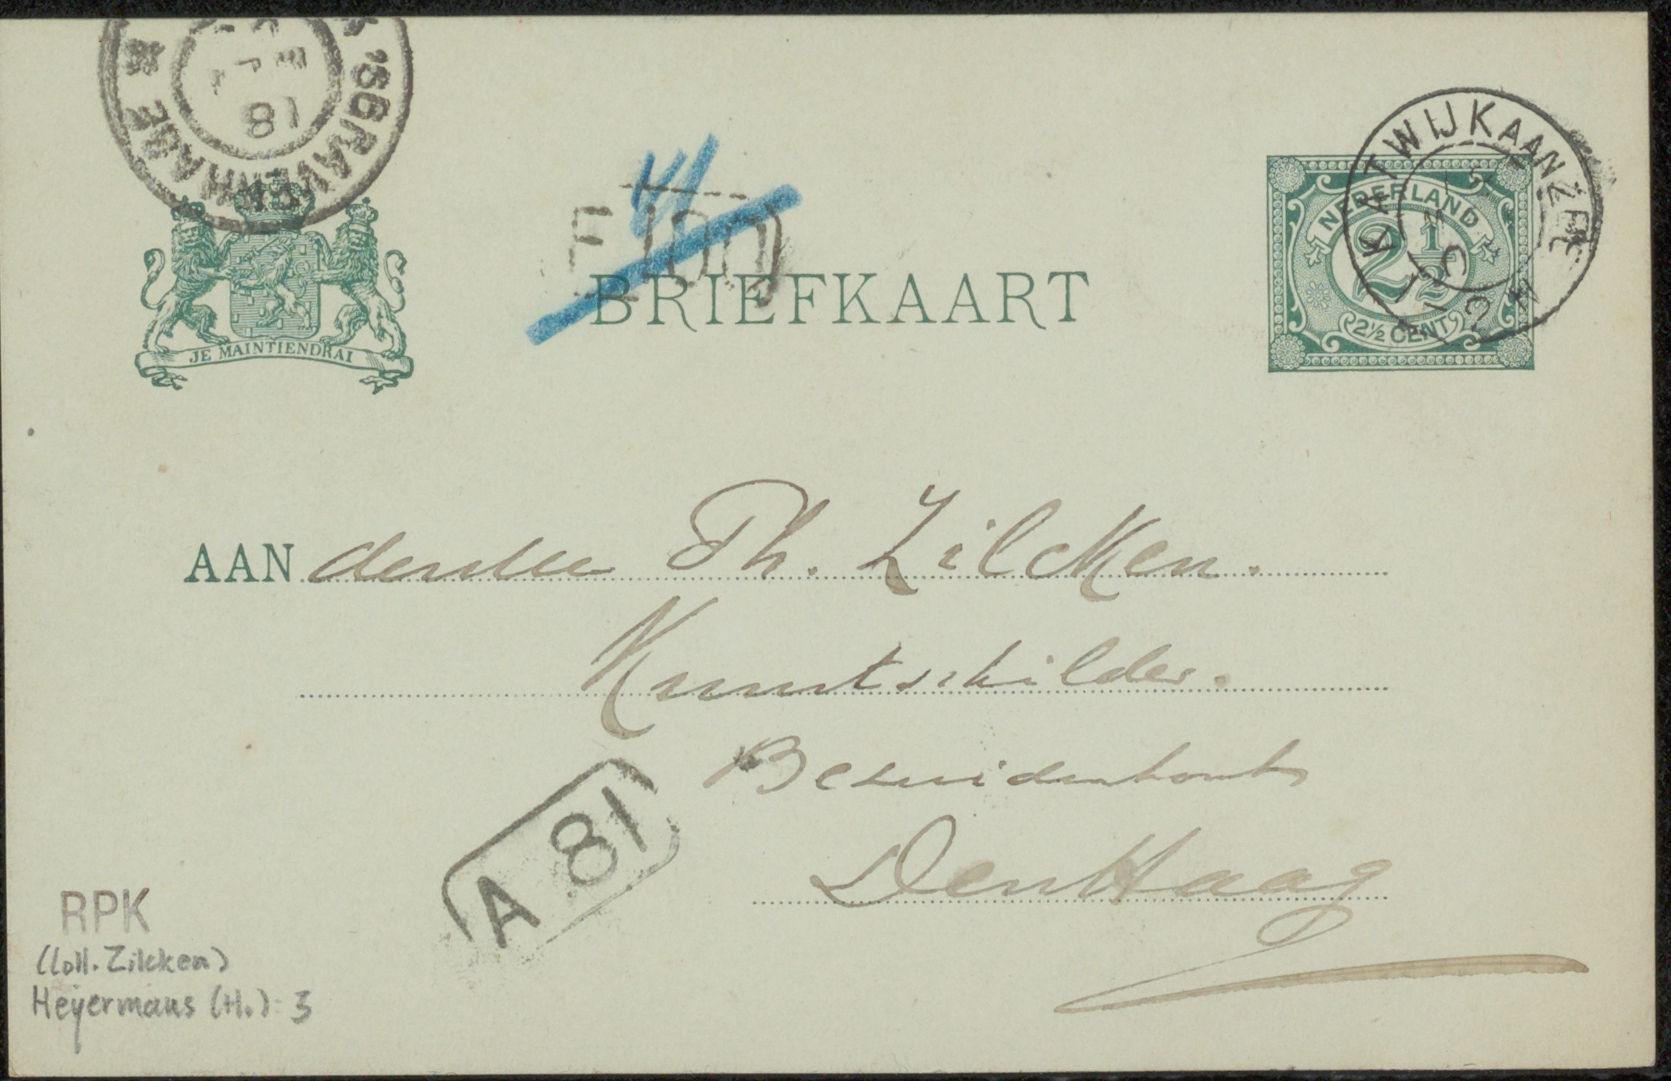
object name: postcard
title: Briefkaart aan Philip Zilcken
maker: herman heijermans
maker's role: schrijver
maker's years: 1864-1924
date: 1903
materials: cardboard, ink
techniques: pen, writing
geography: katwijk aan zee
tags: painter, draughtsman, philip zilcken, money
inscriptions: collector's mark: ‘RPK’